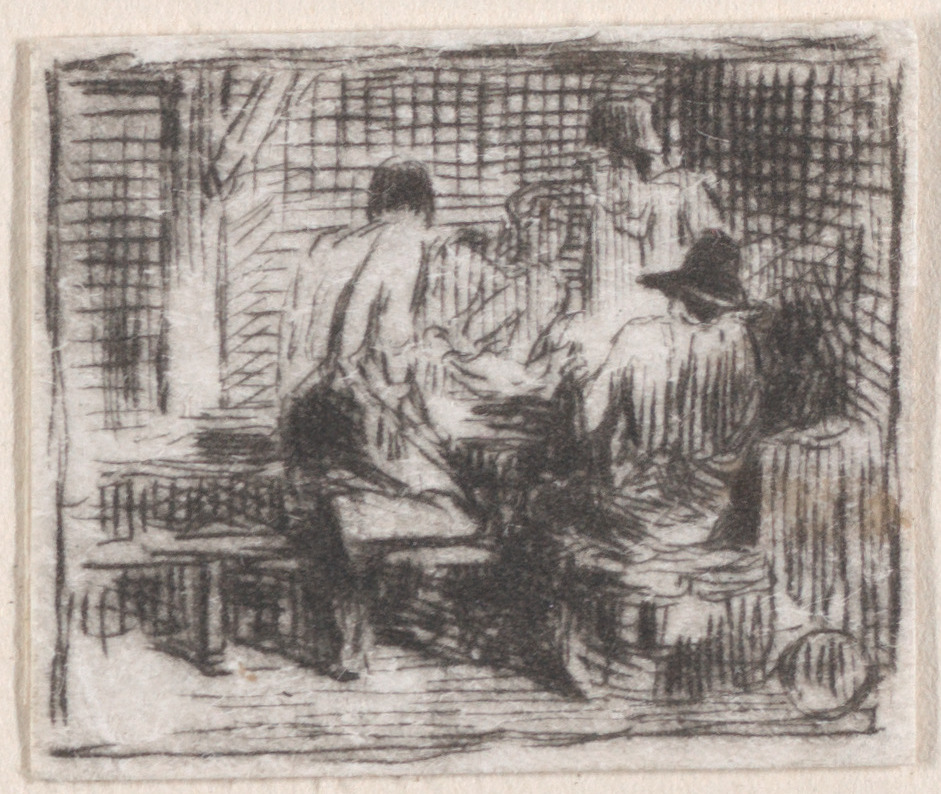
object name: print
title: Drinkers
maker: charles émile jacque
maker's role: artist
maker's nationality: french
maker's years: 1813-1894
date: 1843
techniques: drypoint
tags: men